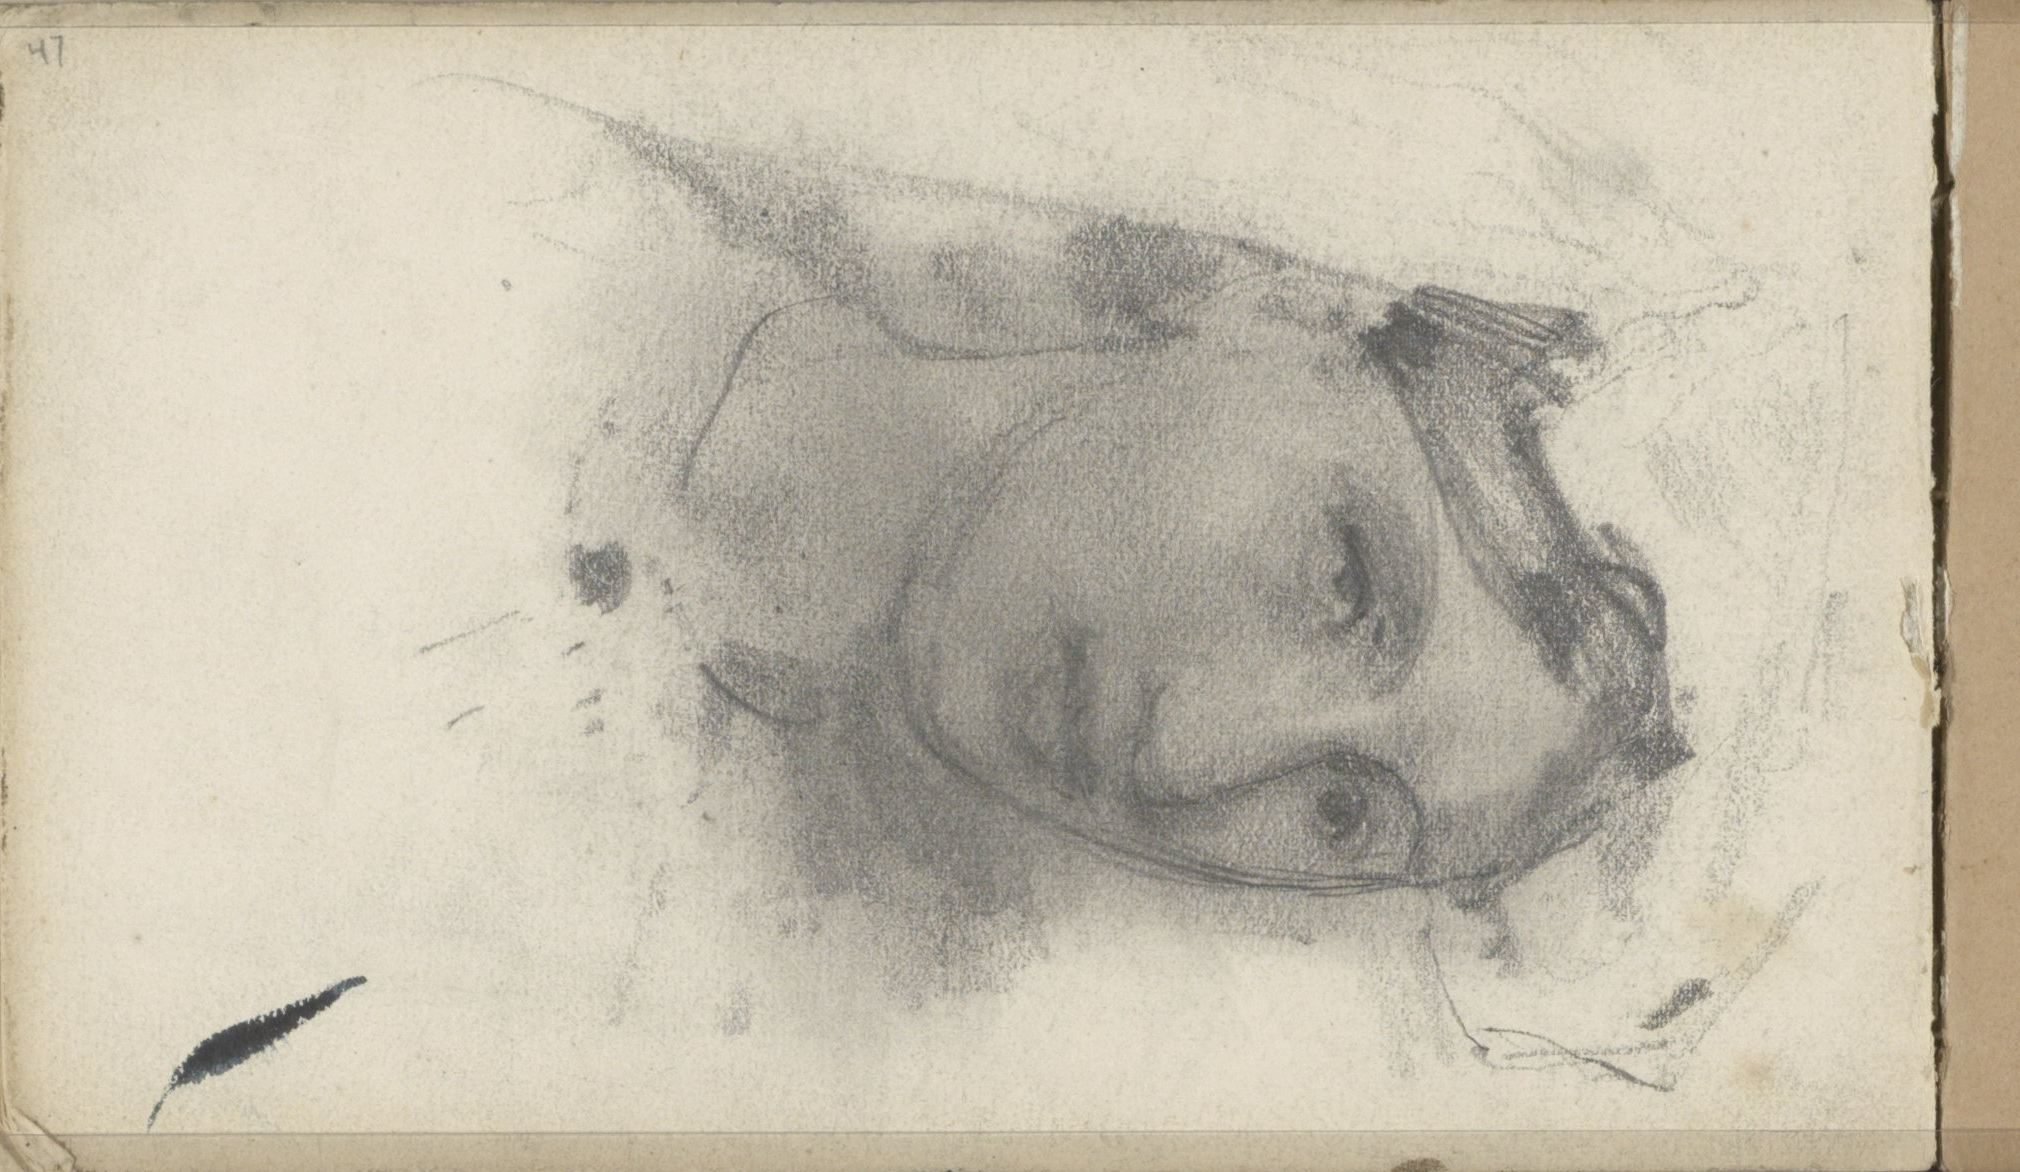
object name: sketchbook leaf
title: Buste van een jonge vrouw in Brabantse klederdracht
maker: george hendrik breitner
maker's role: draughtsman, painter, print maker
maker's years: 1857-1923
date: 1881-1883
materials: paper, pencil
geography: north brabant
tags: adolescent, young woman, maiden, folk costume, regional costume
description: Pagina 47 uit een schetsboek met 30 bladen.